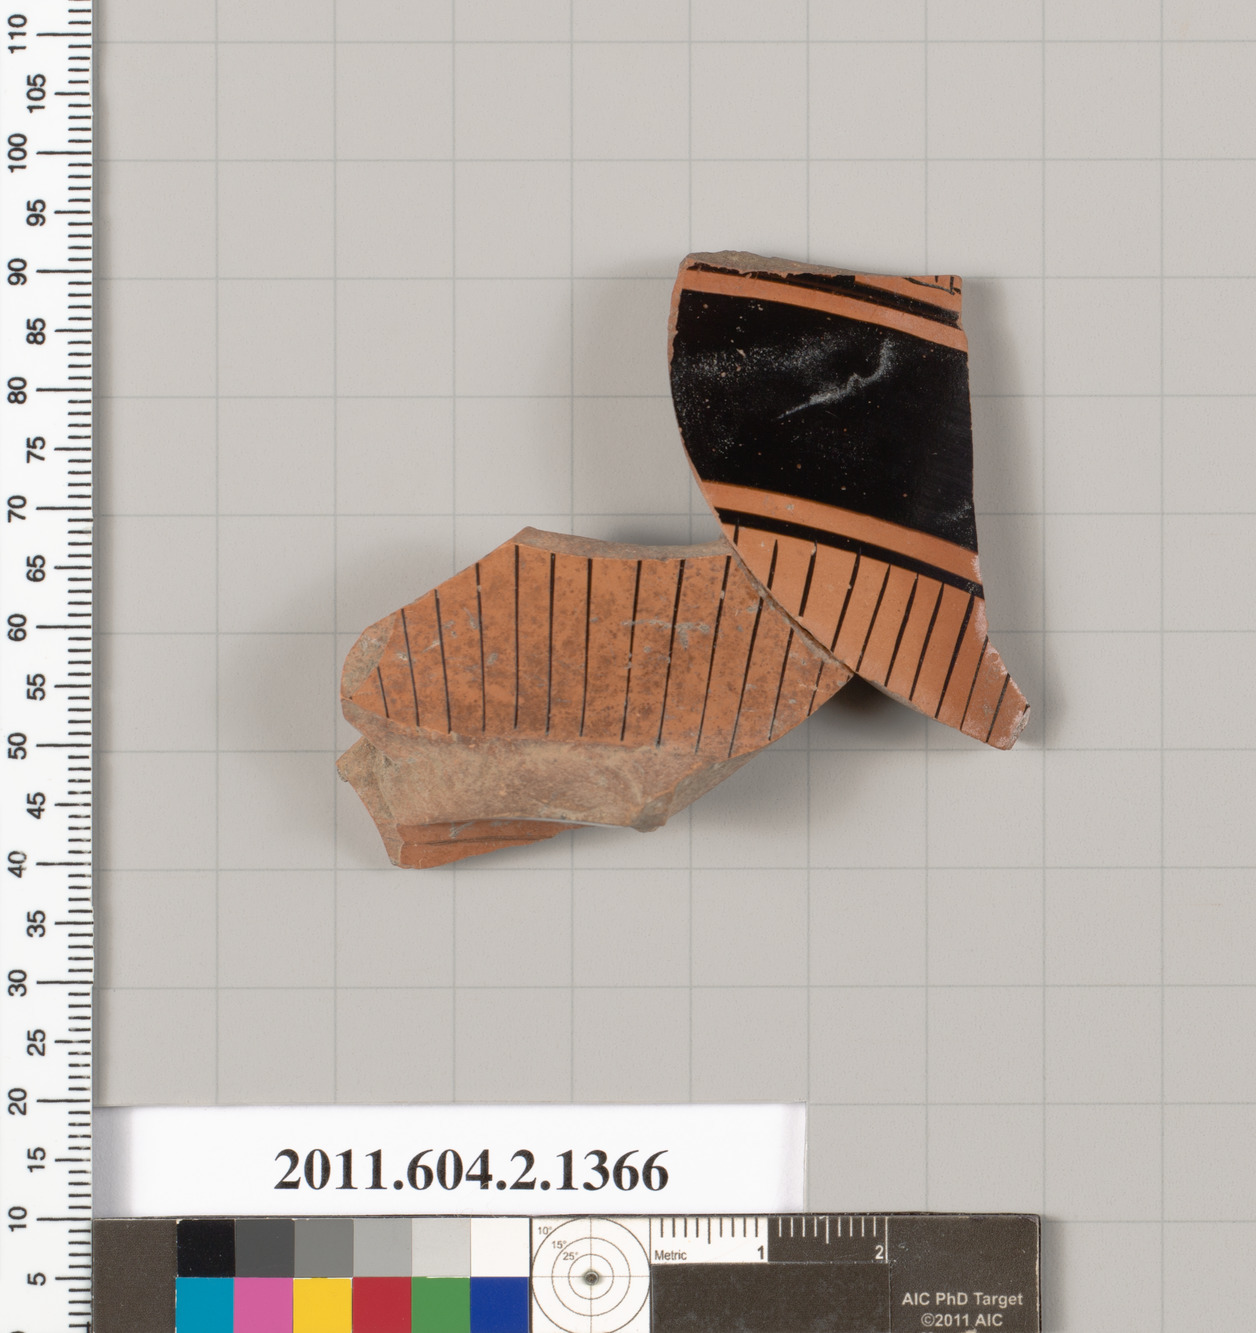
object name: skyphos fragment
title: Terracotta fragment of a skyphos (deep drinking cup)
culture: greek, attic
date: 475-451 BCE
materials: terracotta